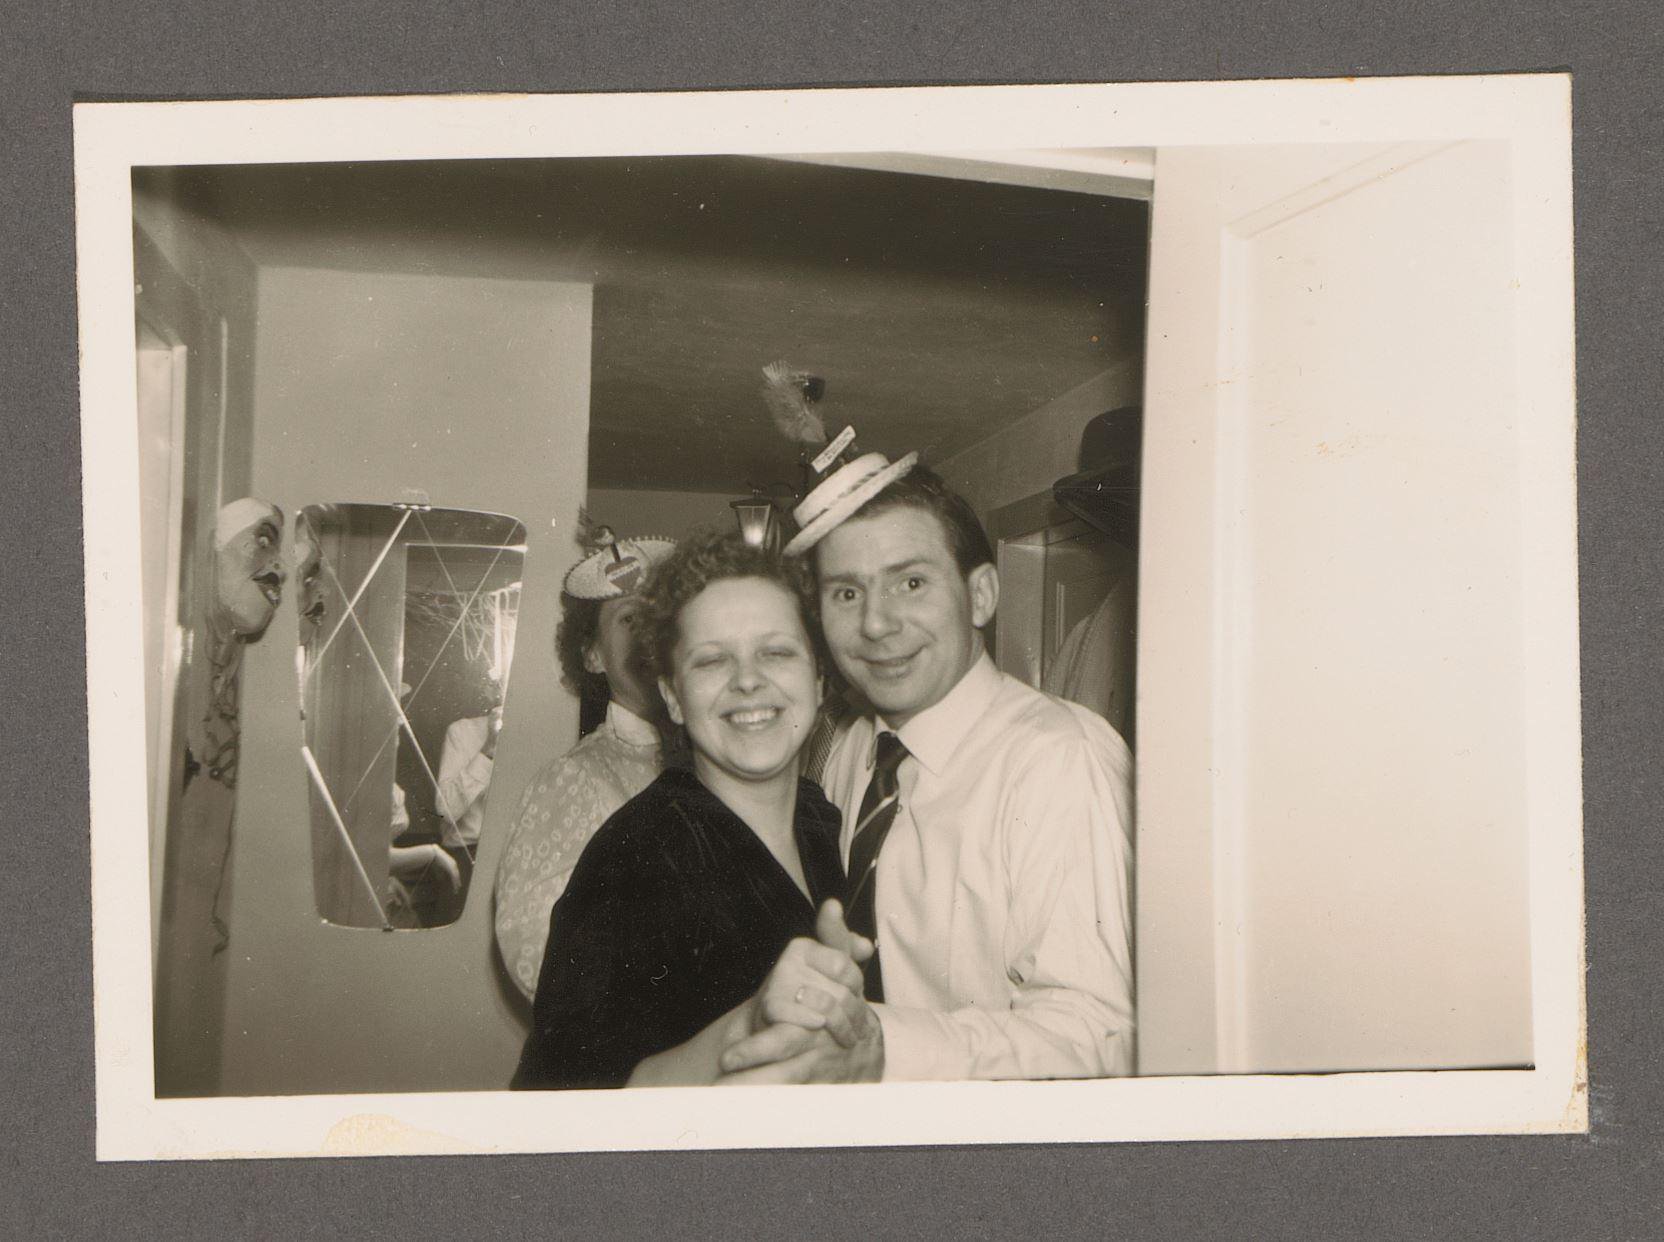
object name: album leaf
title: Man en vrouw op een feest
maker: Anonymous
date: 1930-1945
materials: paper, photographic support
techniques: gelatin silver print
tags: adult woman, adult man, festivities